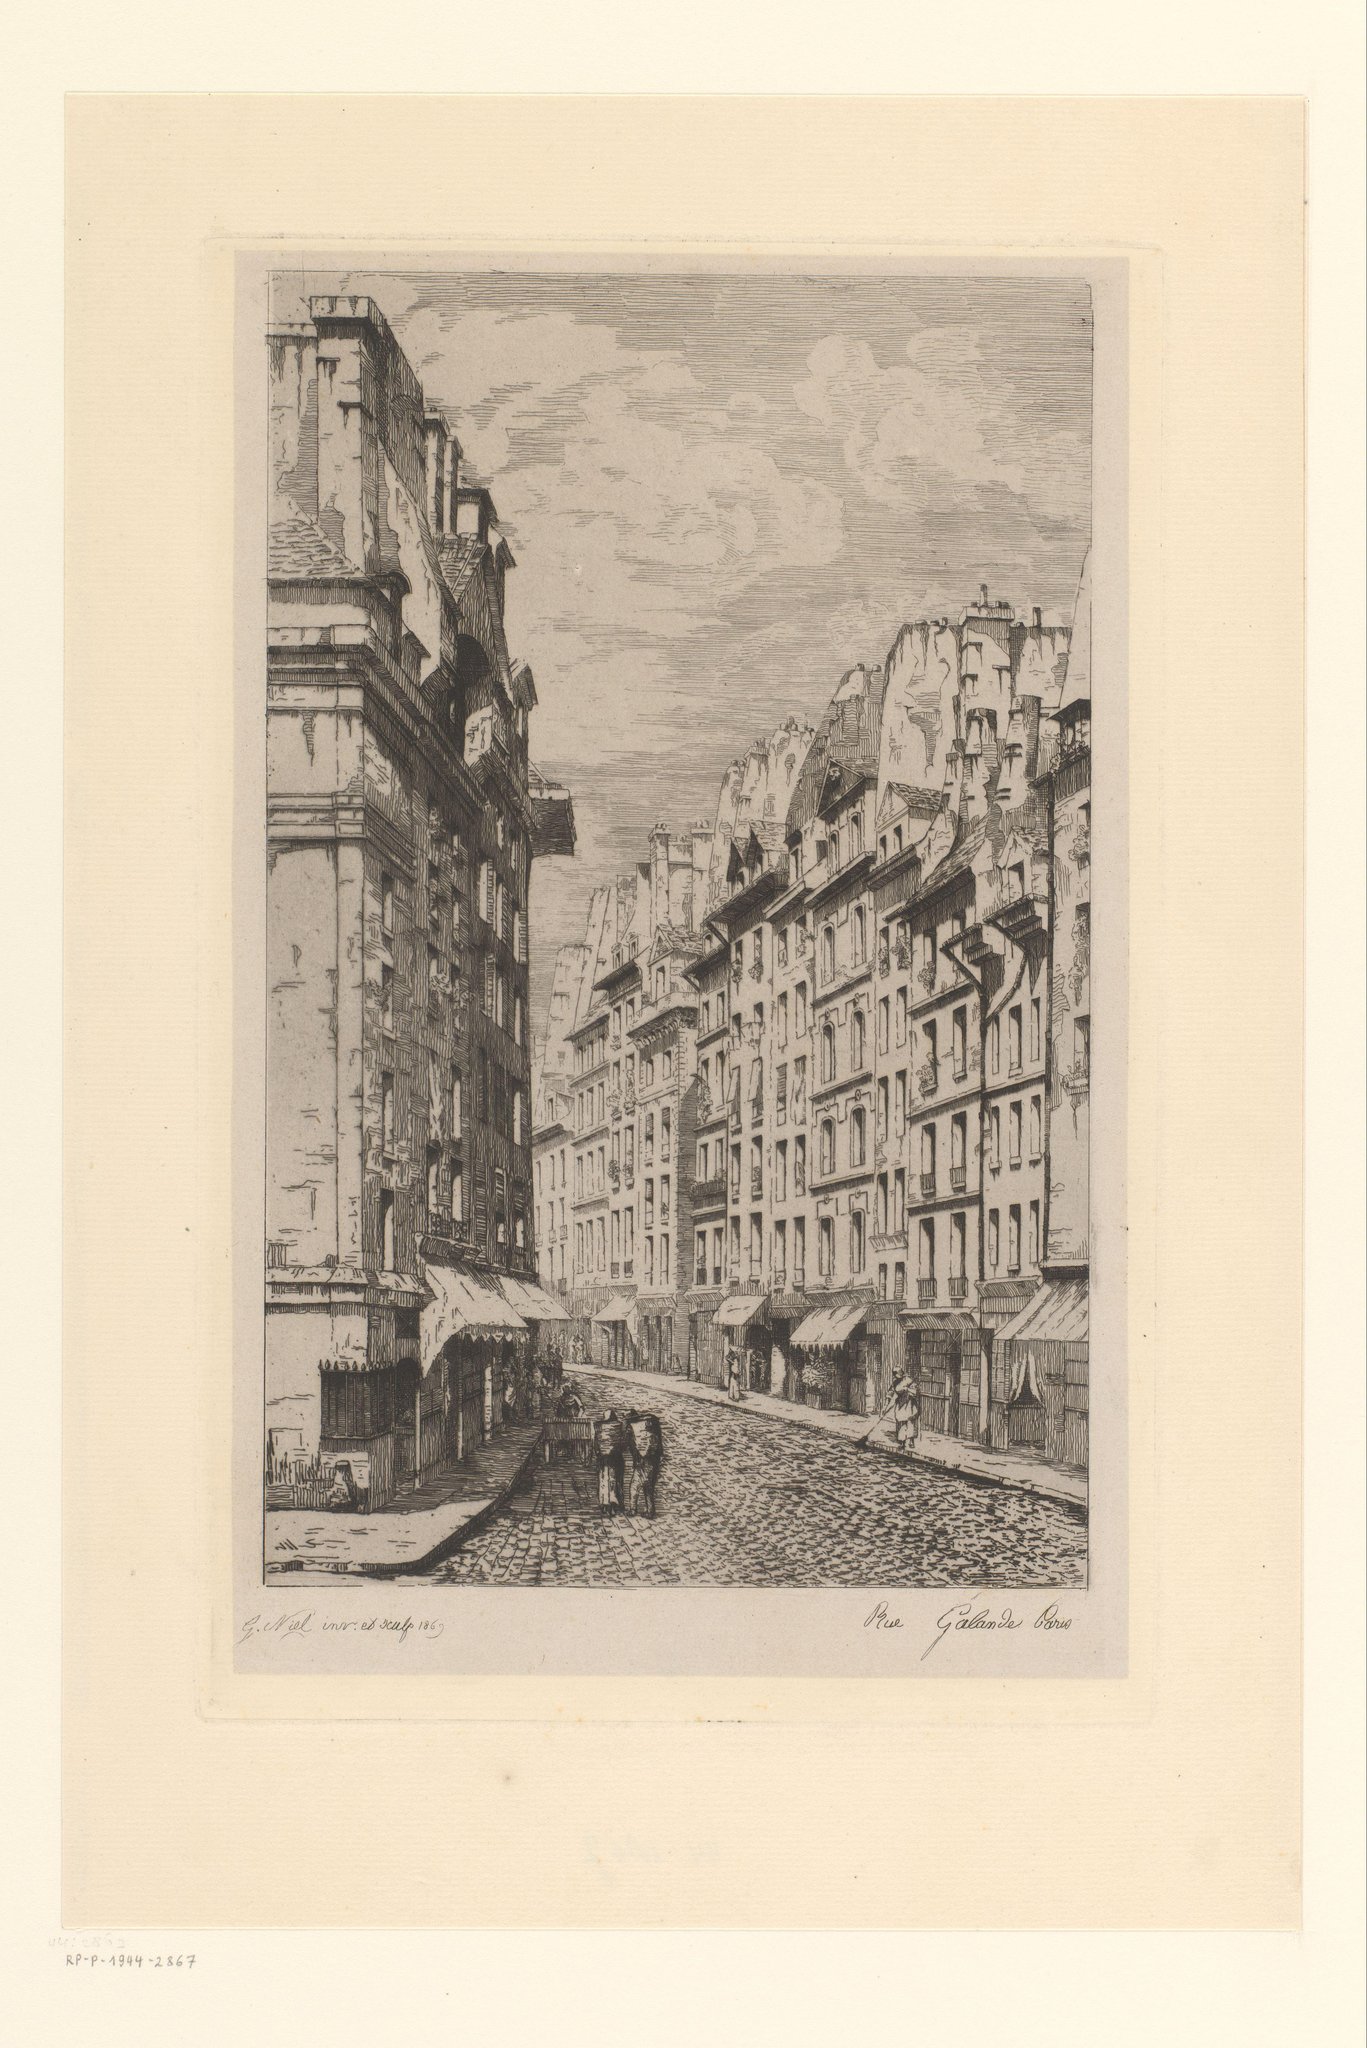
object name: print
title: Gezicht op de rue Galande in Parijs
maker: gabrielle-marie niel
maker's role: print maker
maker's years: 1840-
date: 1869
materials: paper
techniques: drypoint, etching, intaglio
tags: street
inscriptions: collector's mark: Lugt 2760, collector's mark: Lugt 2228